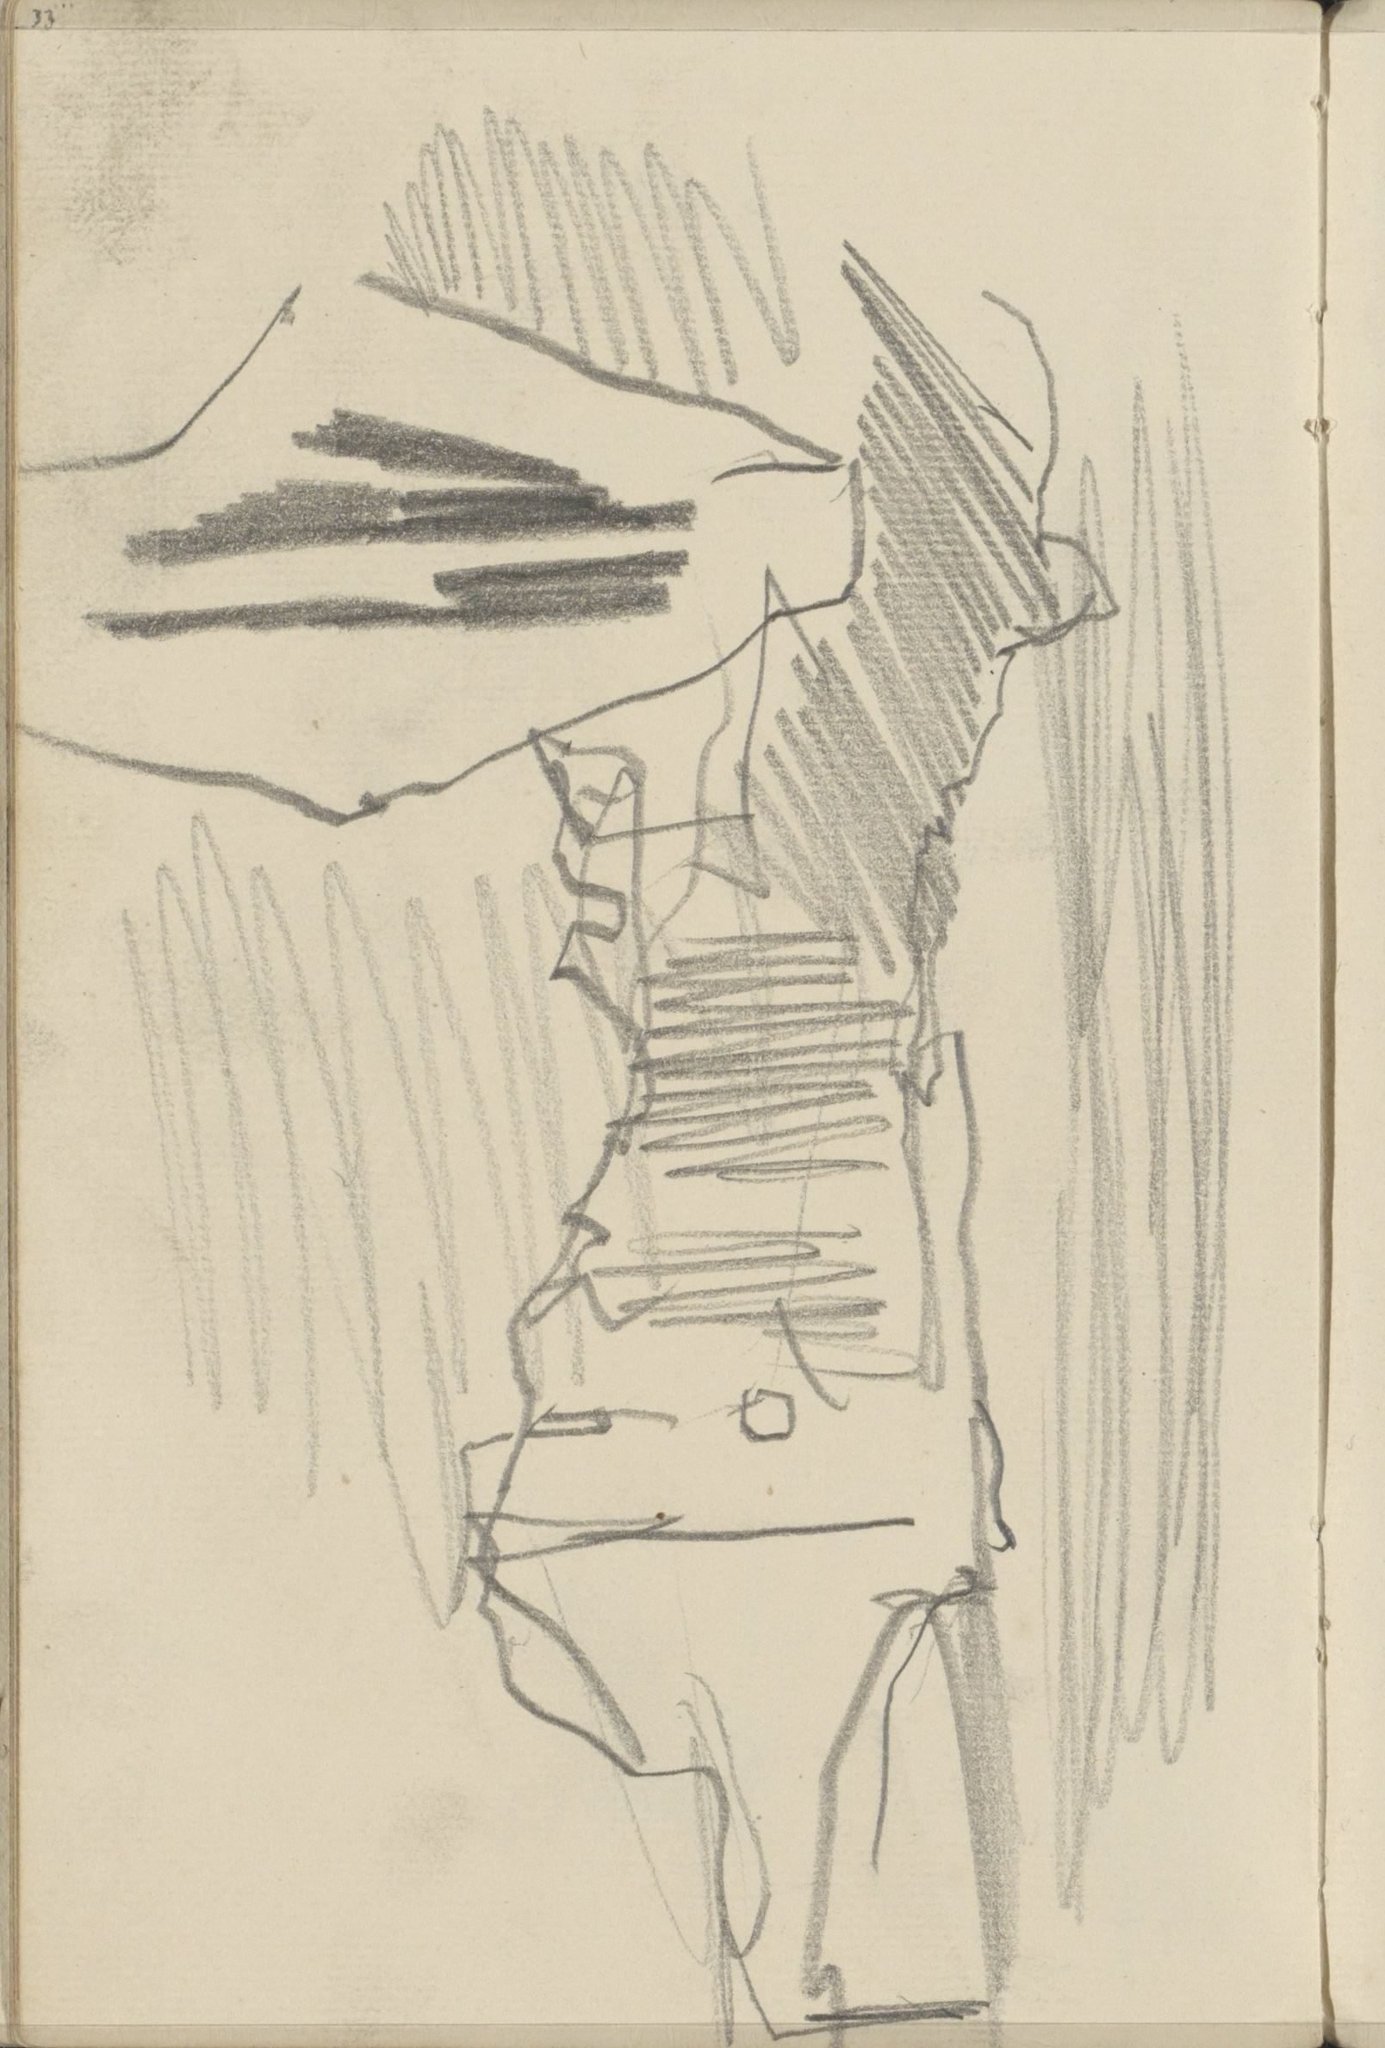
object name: sketchbook leaf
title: Studie, mogelijk een stadsgezicht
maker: george hendrik breitner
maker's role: draughtsman, painter, print maker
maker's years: 1857-1923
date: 1886-1898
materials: paper, pencil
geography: amsterdam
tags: city-view, and landscape with man-made constructions, civic architecture; edifices; dwellings, amsterdam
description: Pagina 33 uit een schetsboek met 18 bladen.